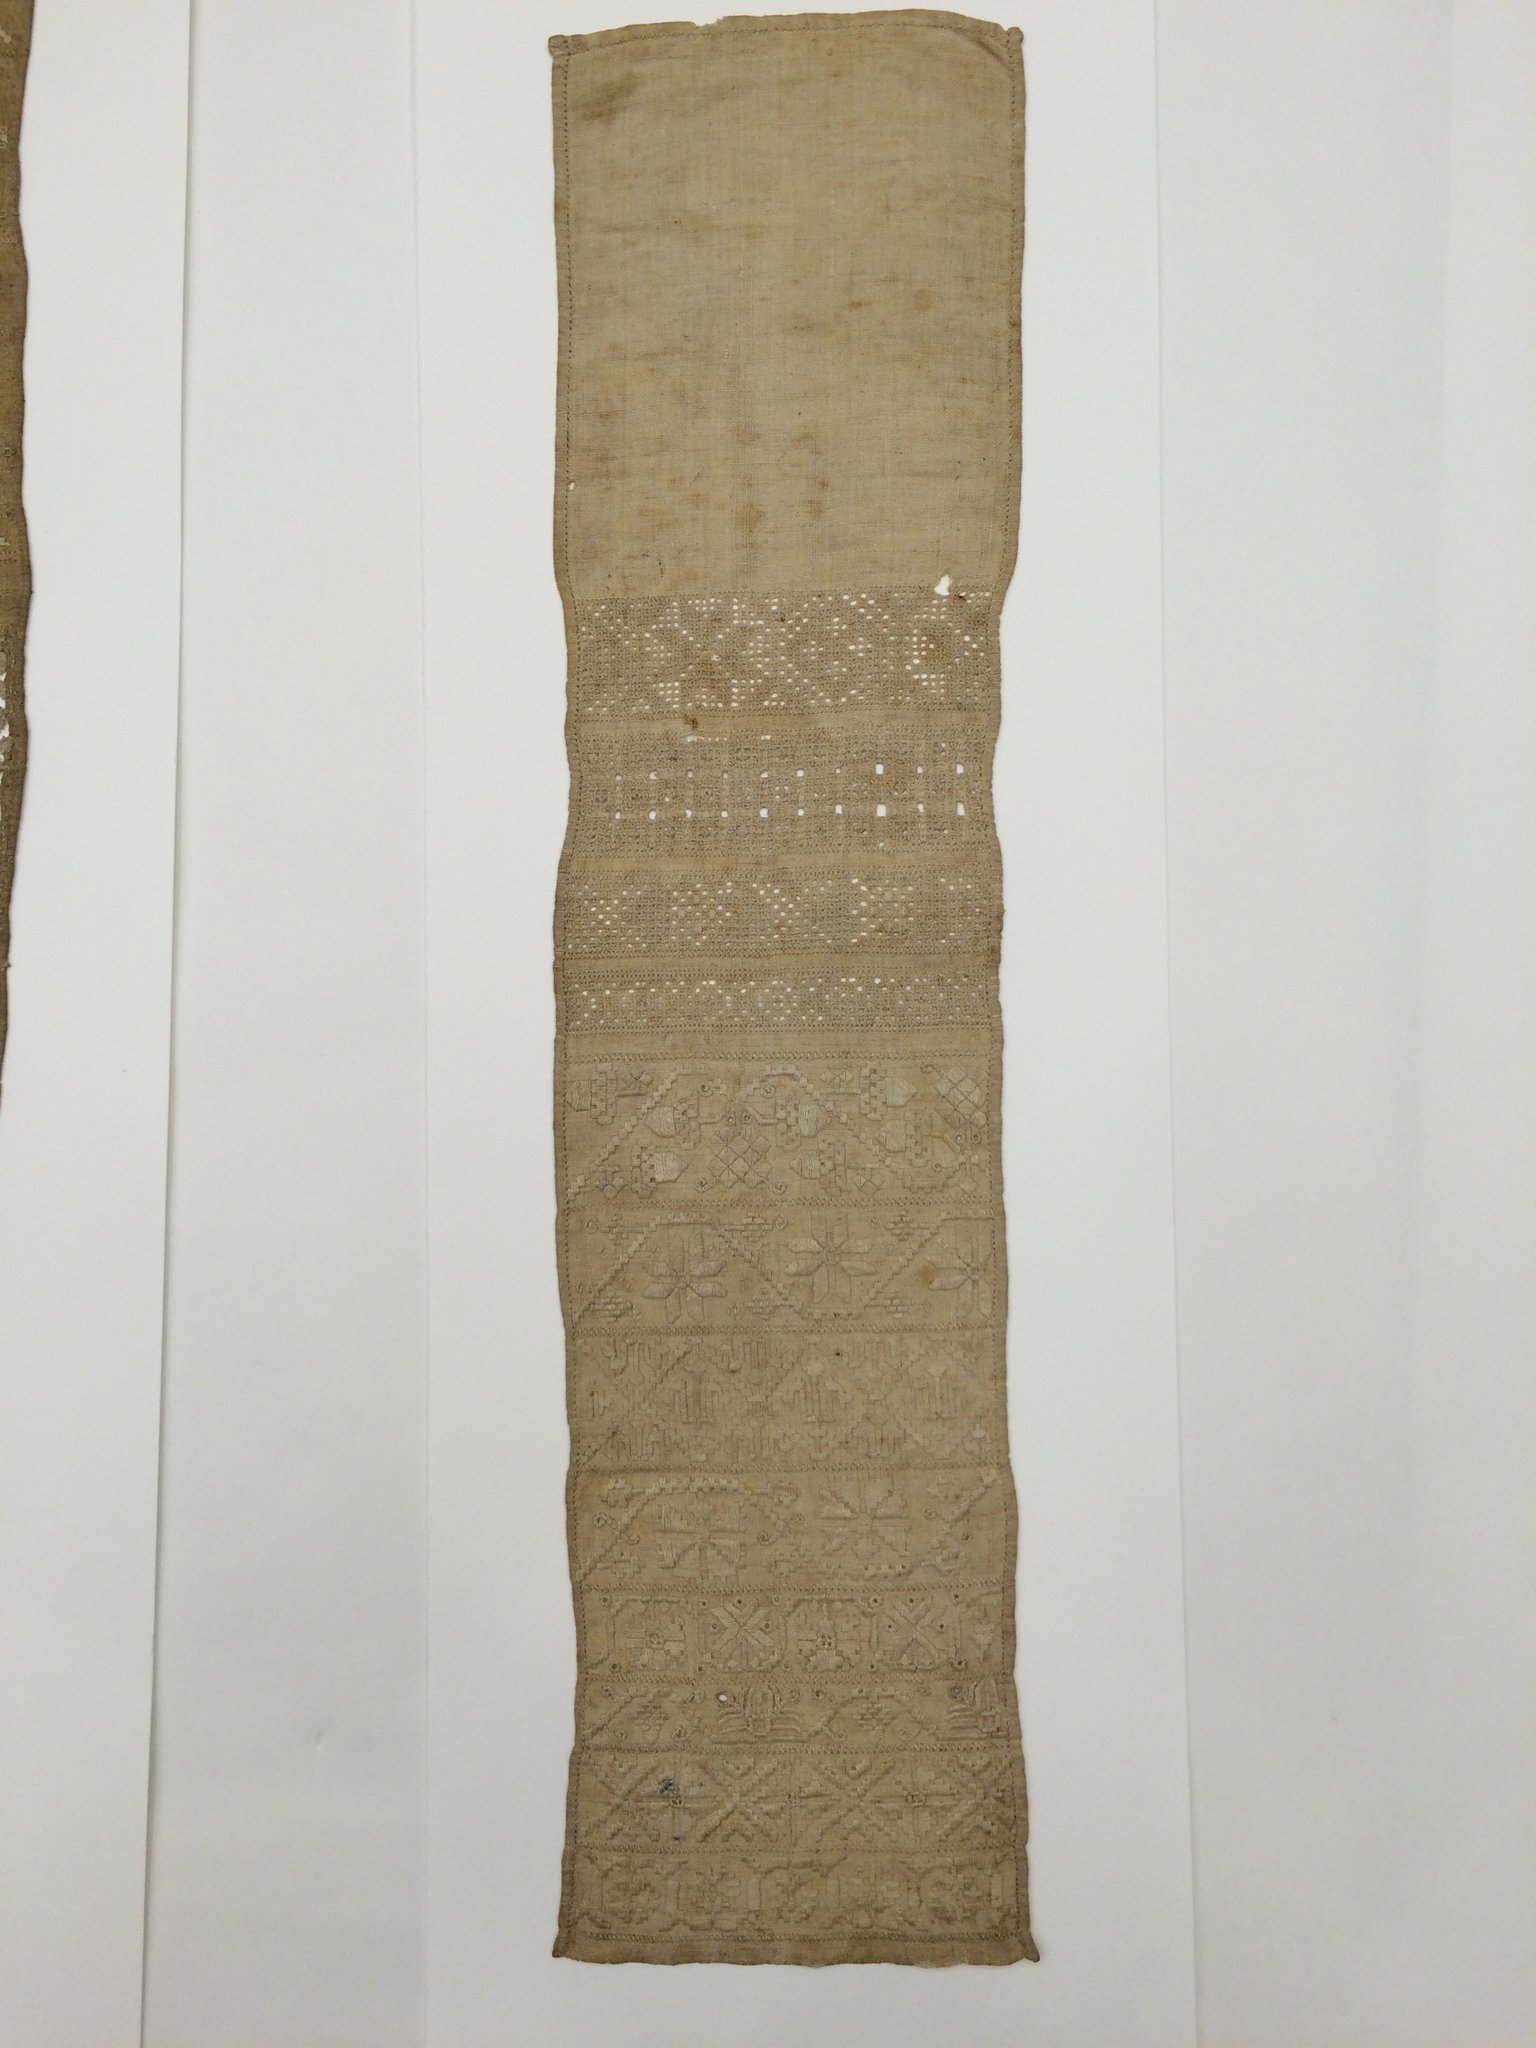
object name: sampler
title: Embroidered whitework sampler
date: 1601-1700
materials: linen, silk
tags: flowers